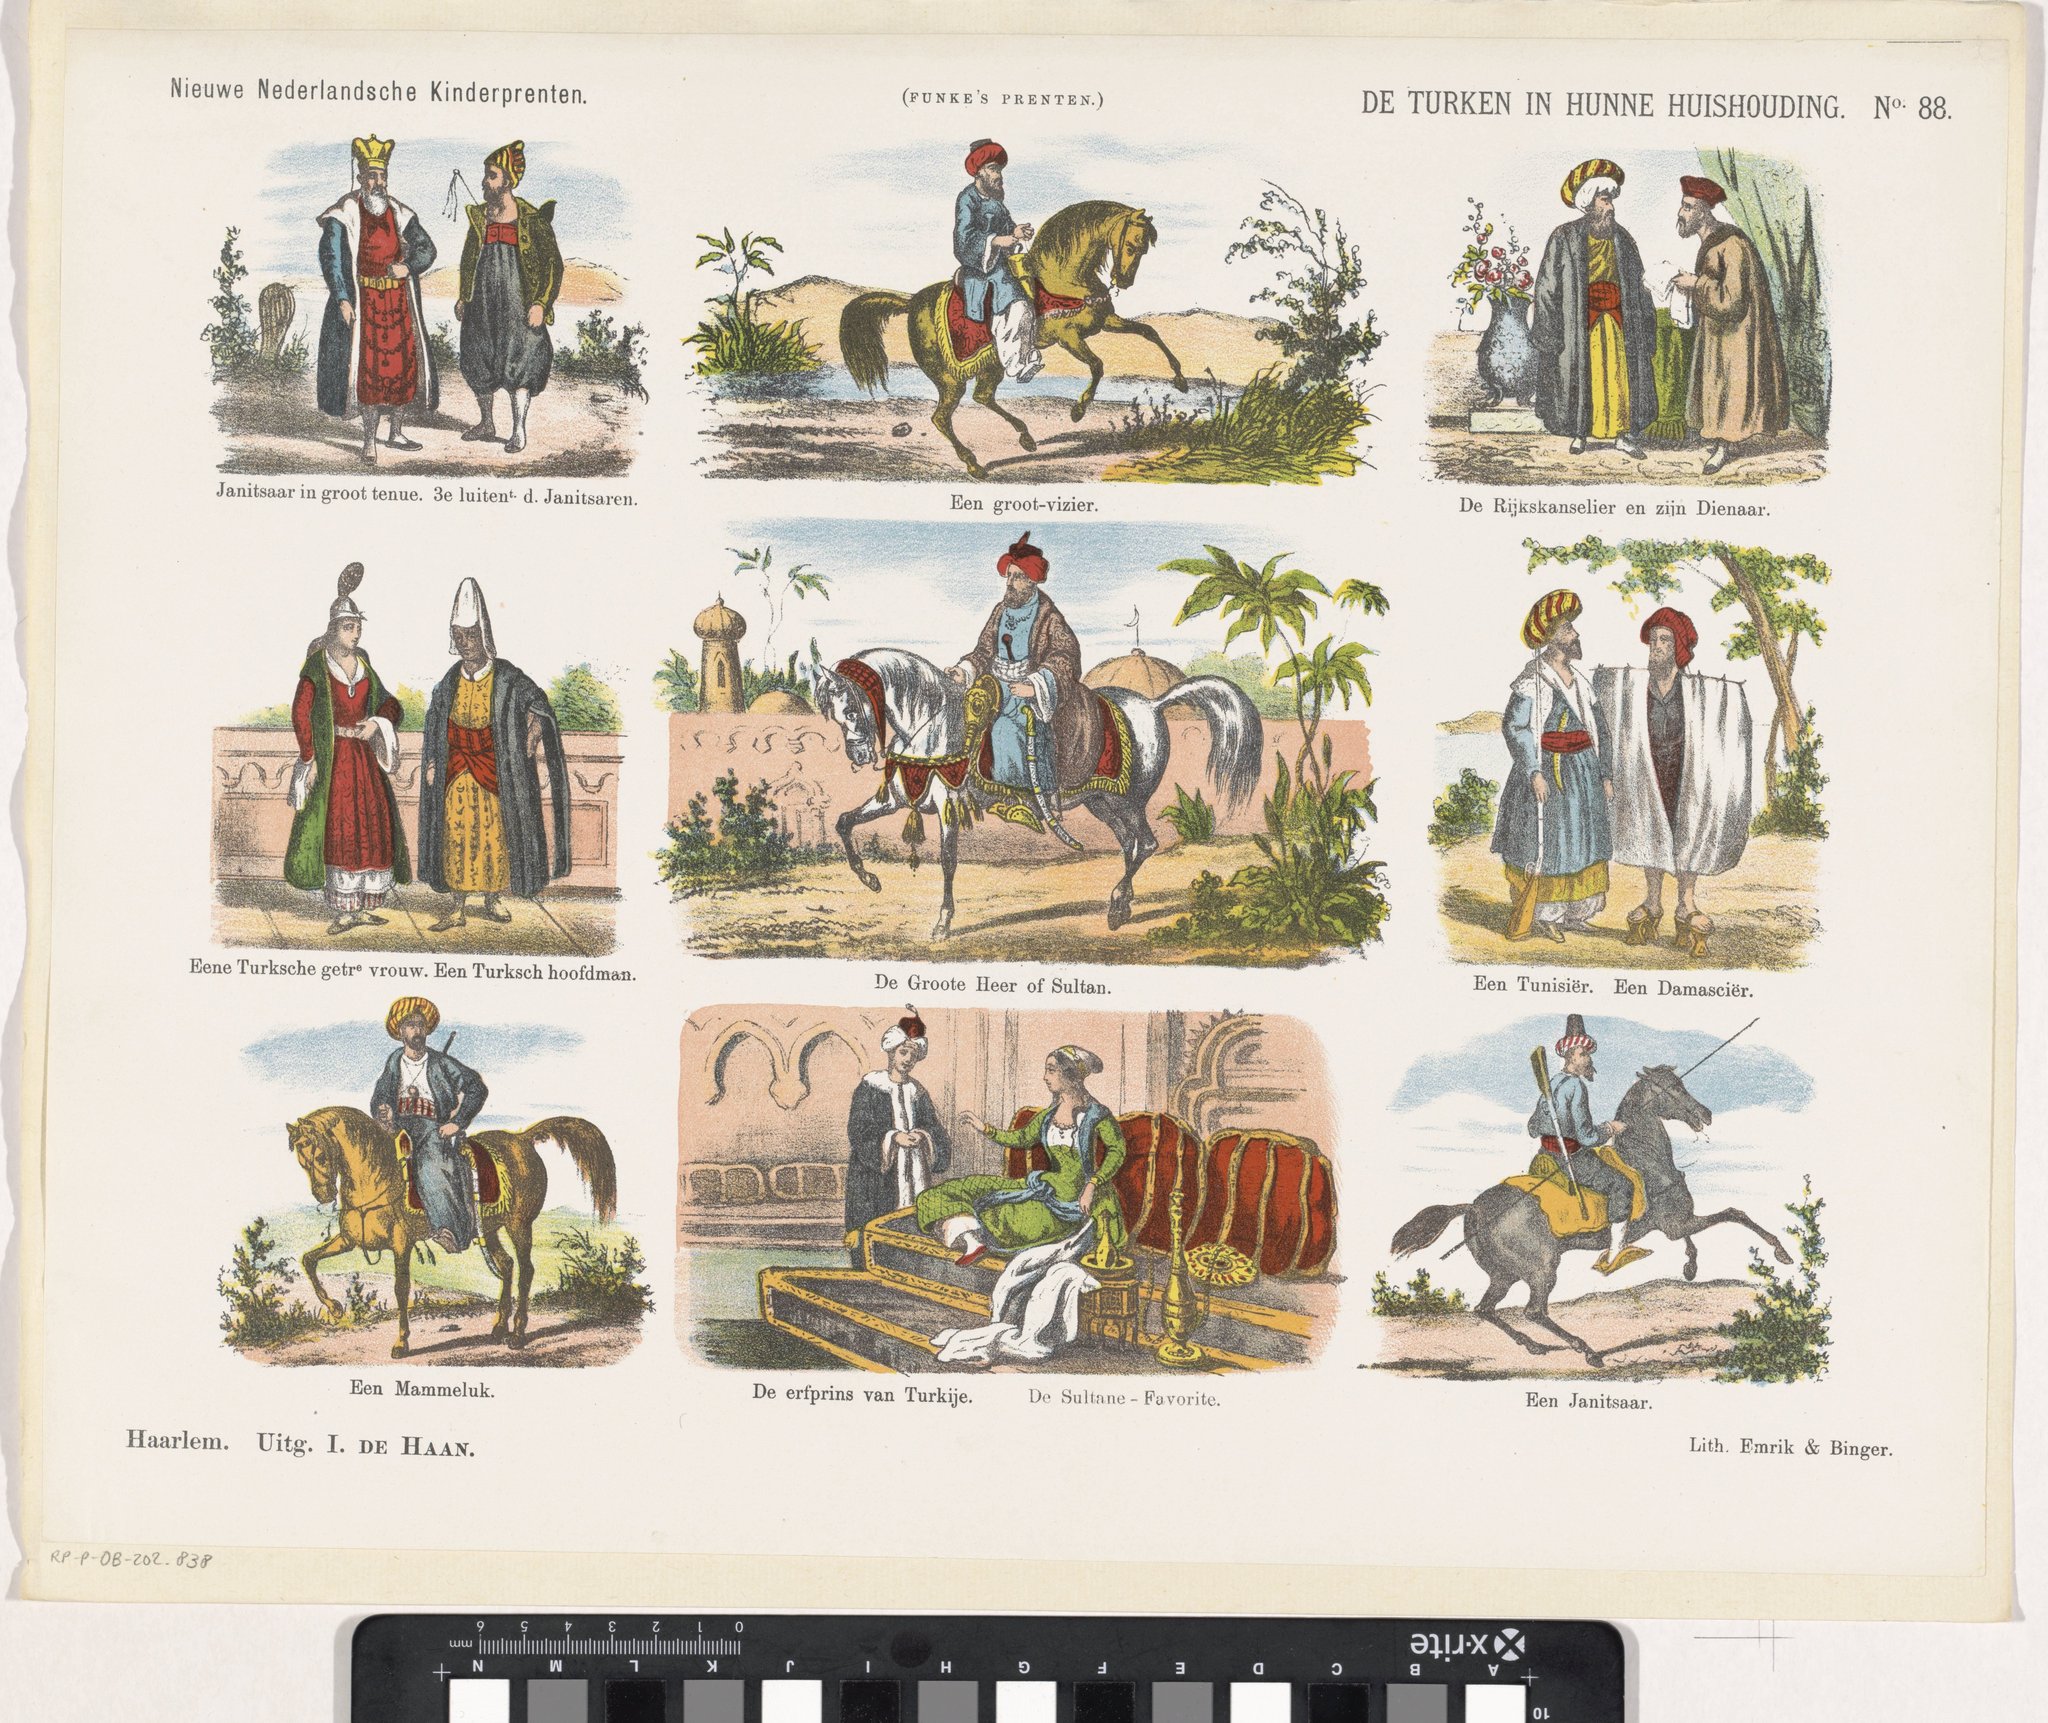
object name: popular print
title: De Turken in hunne huishouding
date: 1875-1903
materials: paper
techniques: lithograph, letterpress printing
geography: haarlem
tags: asiatic races and peoples: turks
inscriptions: collector's mark: Lugt 2760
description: Blad met 9 voorstellingen van Turken. Onder elke afbeelding een onderschrift. Genummerd rechtsboven: No. 88.